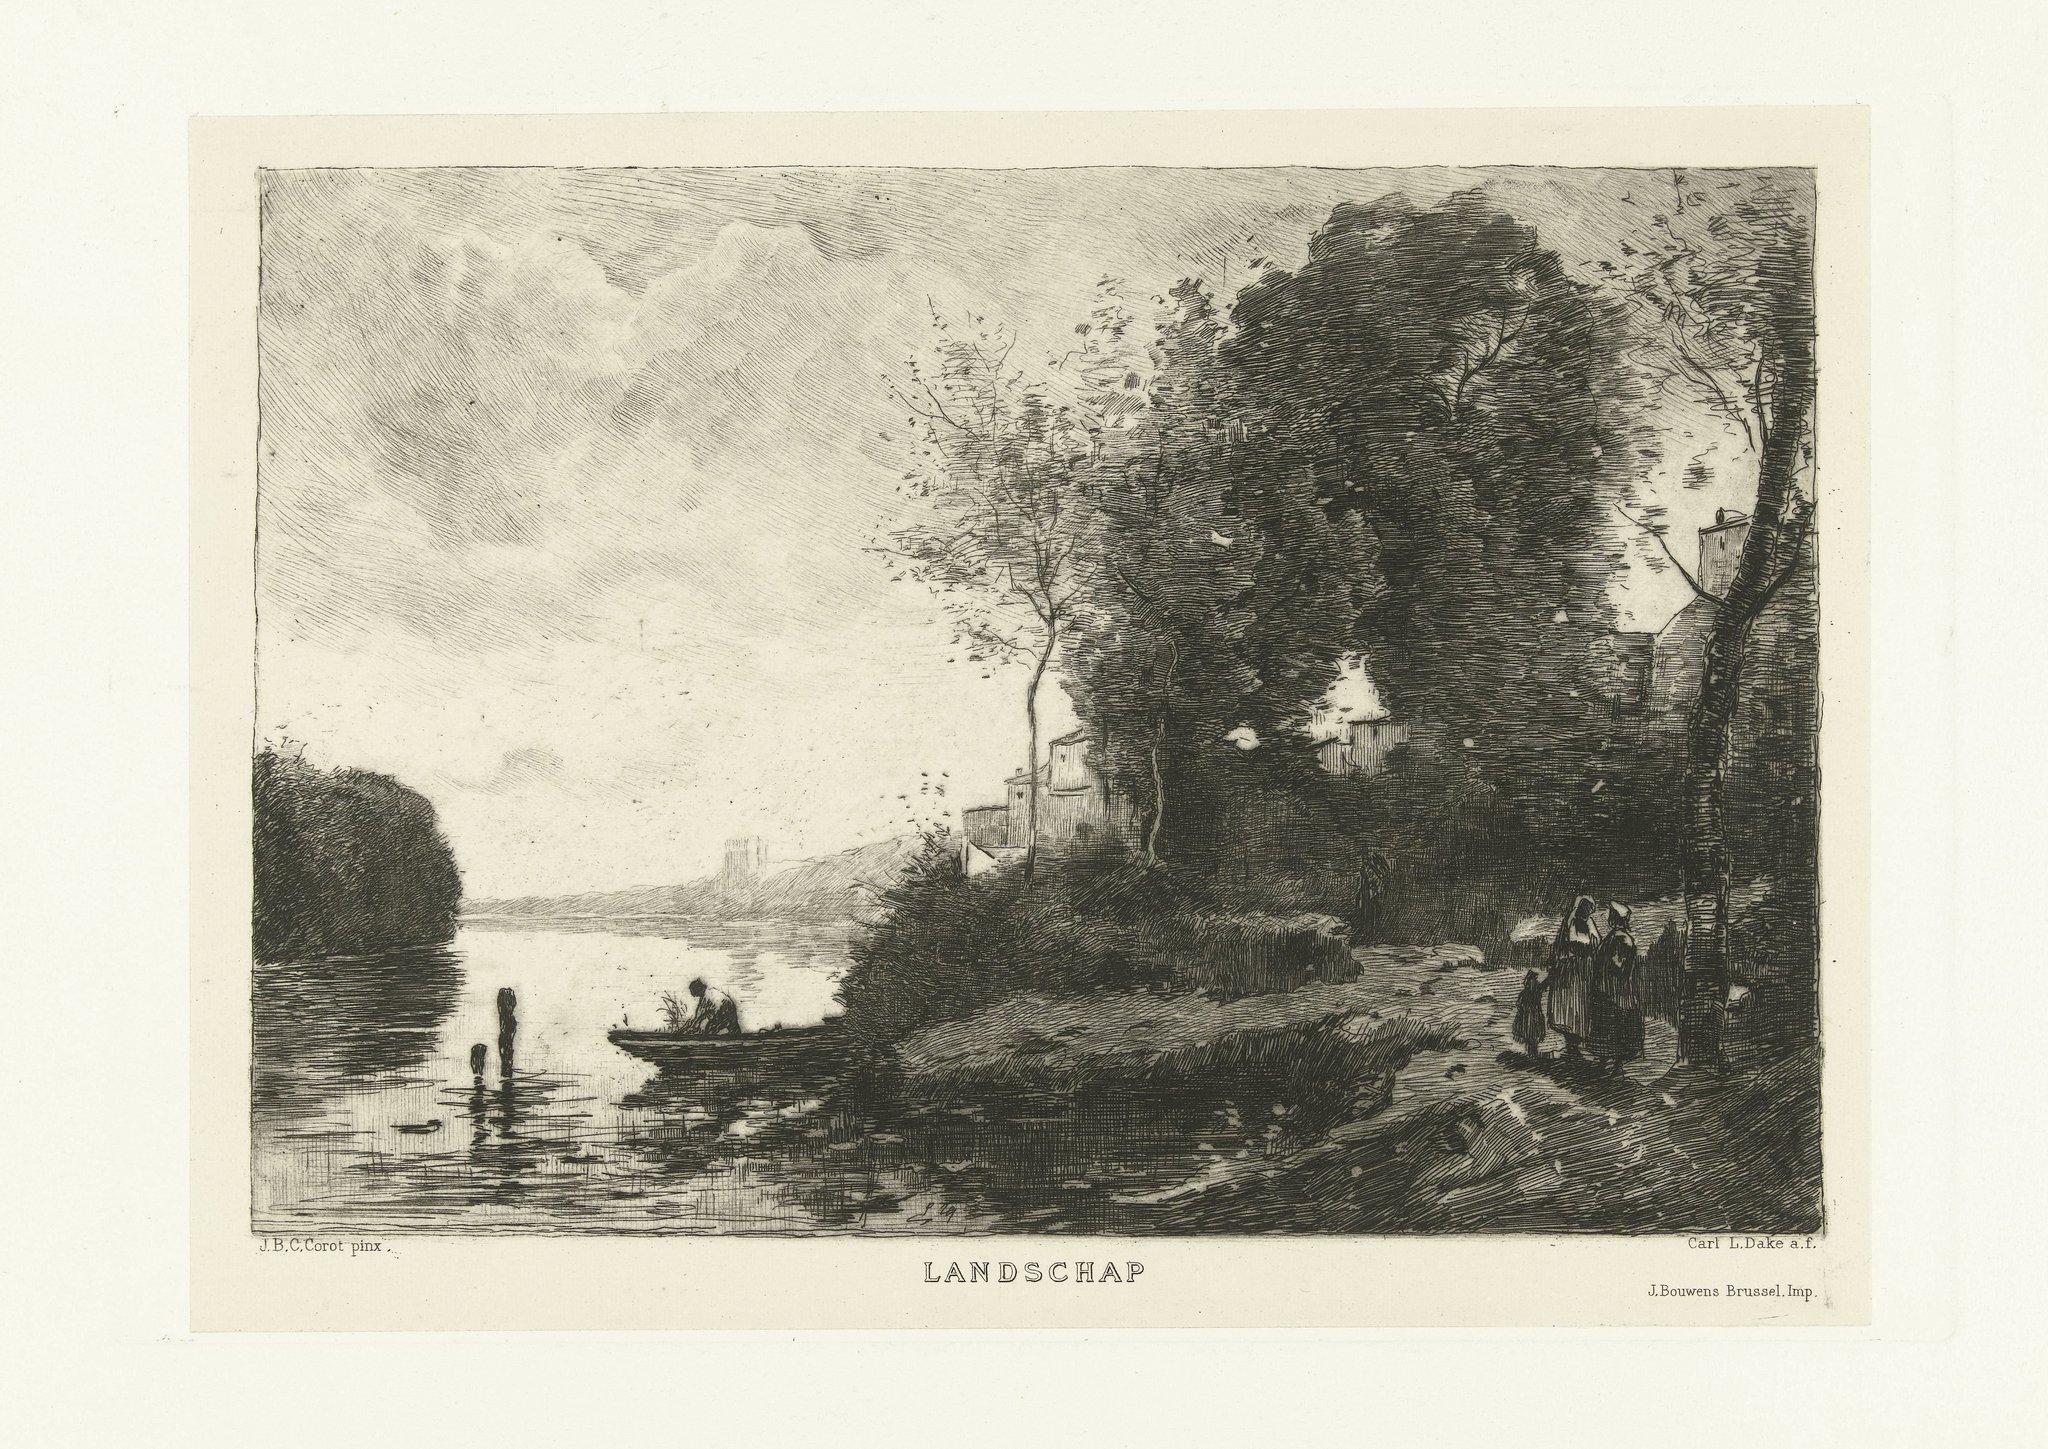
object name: print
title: Landschap met bomen en huizen aan rivier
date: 1867-1889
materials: paper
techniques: drypoint, etching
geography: brussels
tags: river, river bank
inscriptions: collector's mark: Lugt 2228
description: Prent naar schilderij van Camille Corot. Prent gebruikt voor: Ets-portefeuille "De Distel", etsen van Nederlandsche kunstenaars, Amsterdam 1889-1890